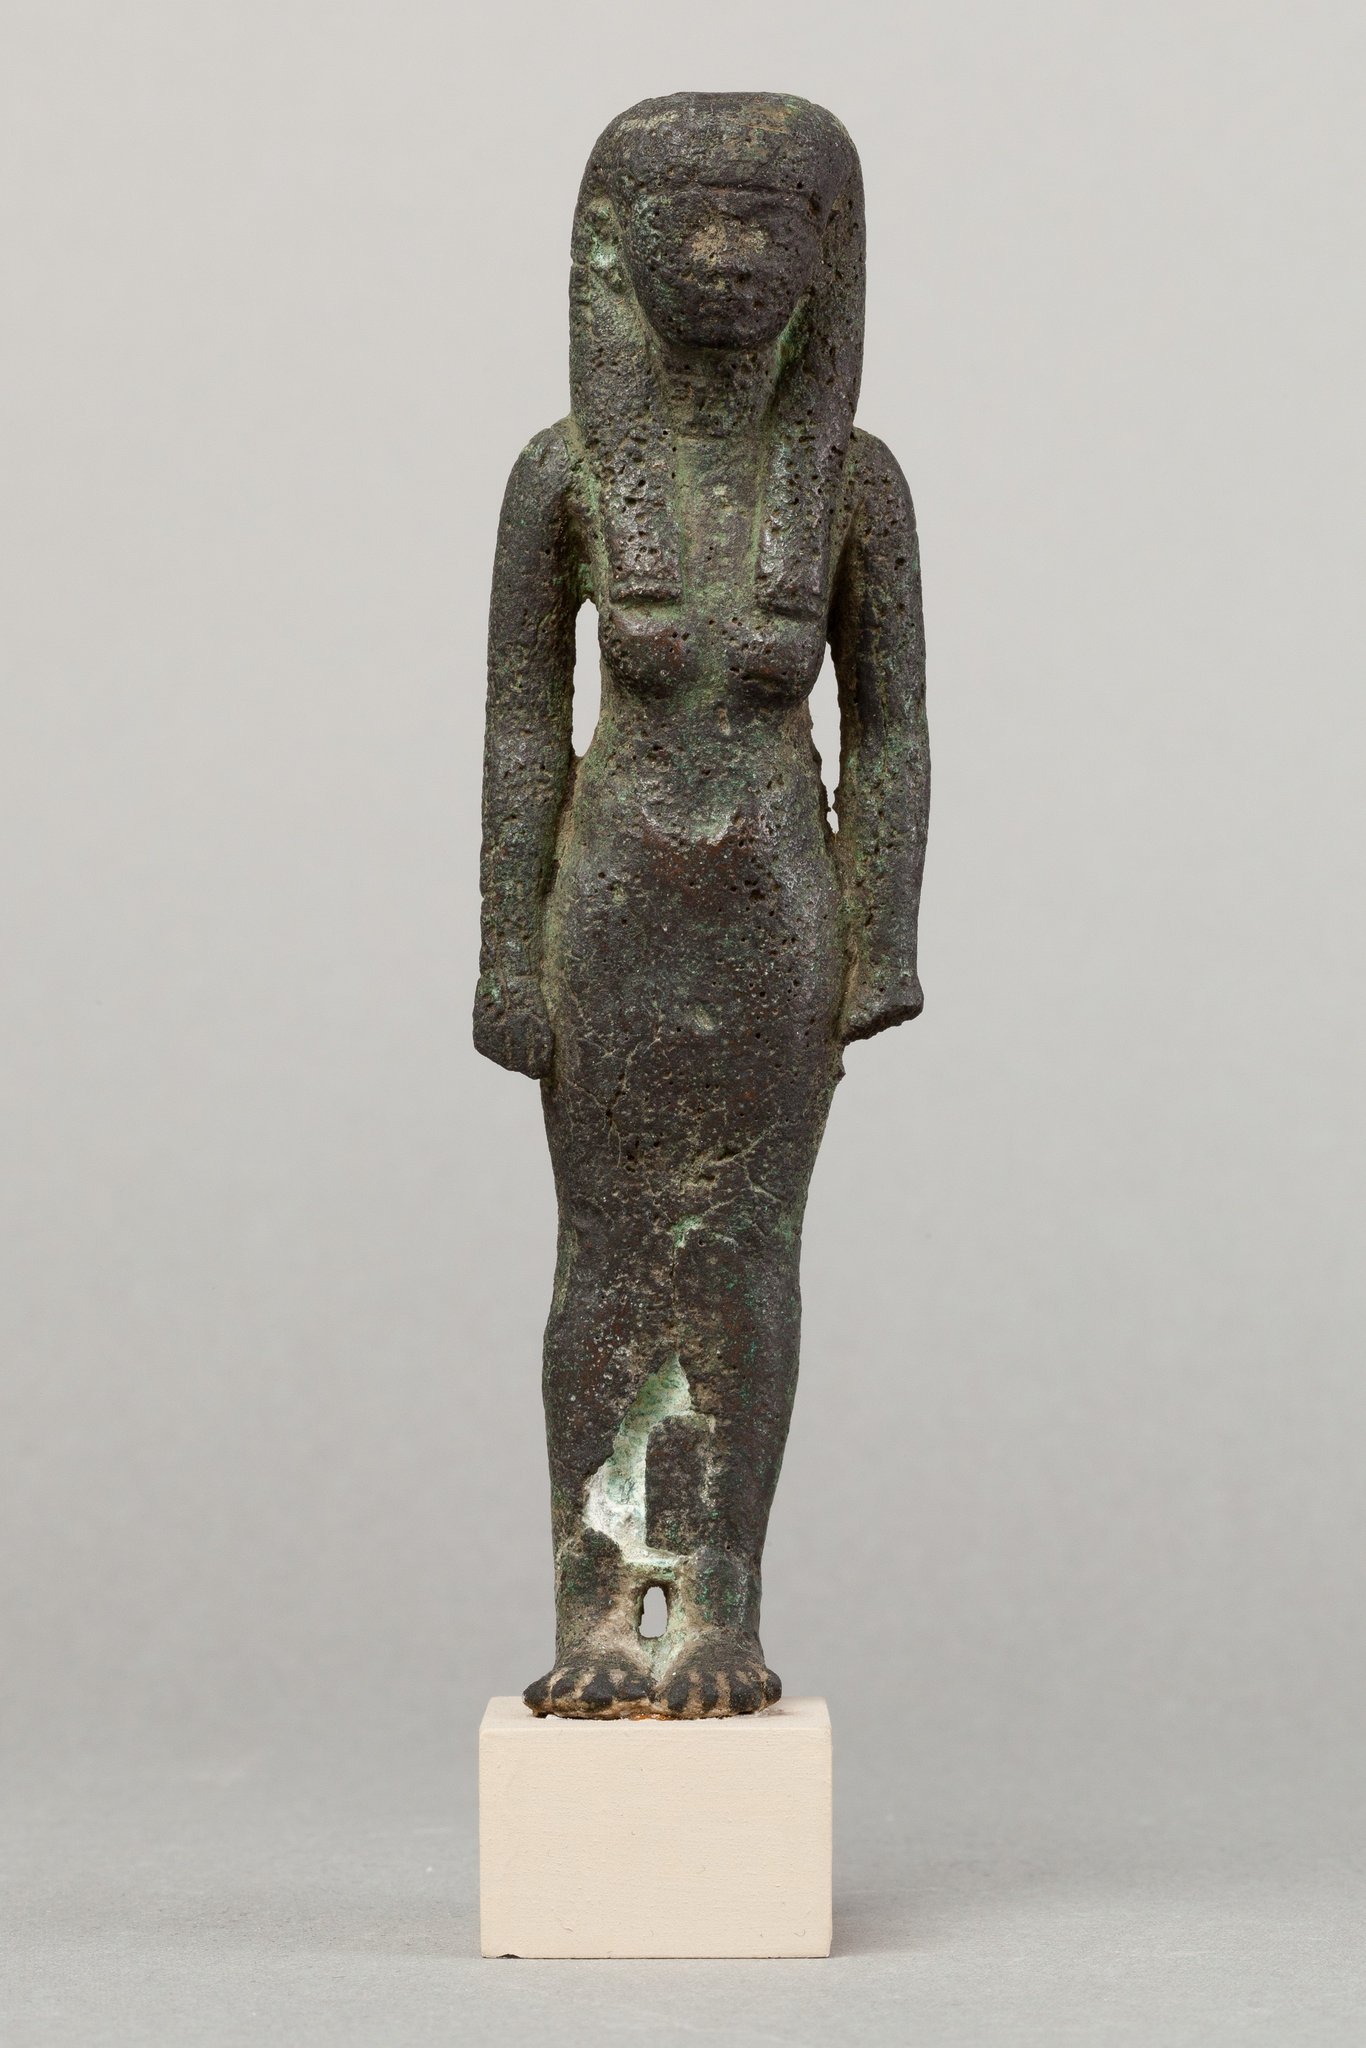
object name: statuette, nephthys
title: Goddess, attribute missing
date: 664-630 BCE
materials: metal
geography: egypt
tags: goddess